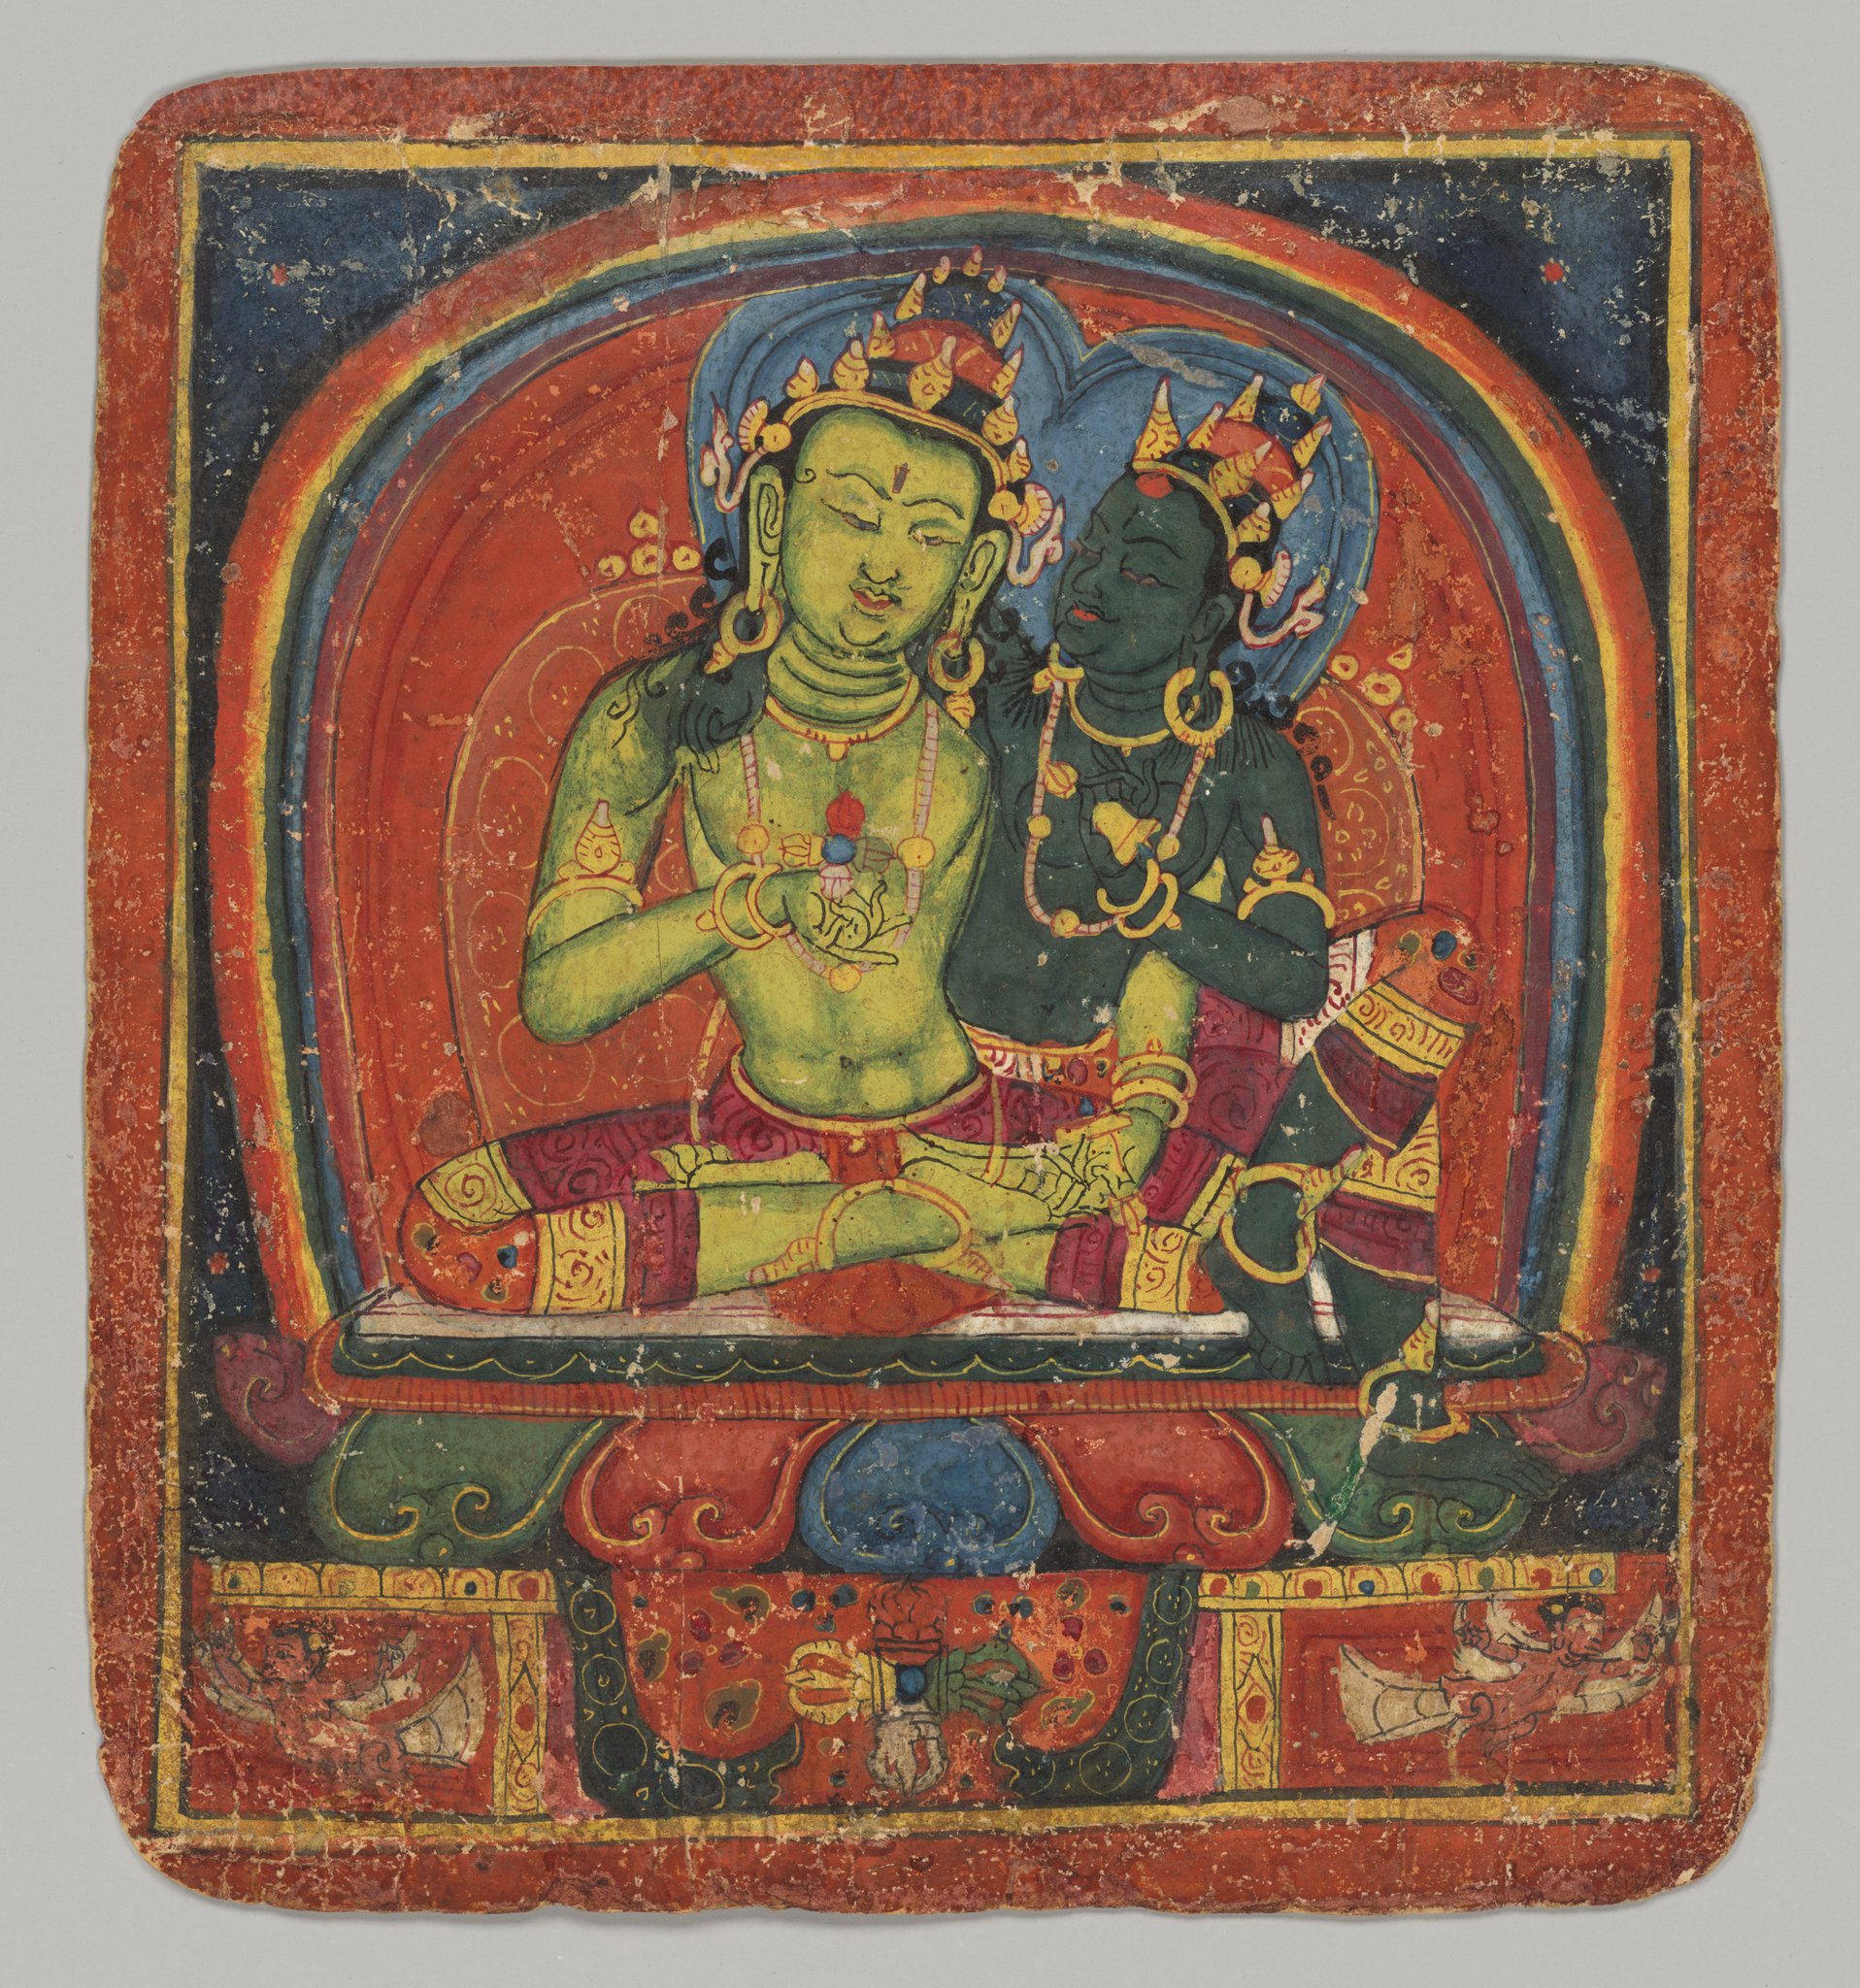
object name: initiation card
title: Initiation Card (Tsakalis): Amoghasiddhi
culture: tibetan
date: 1401-1433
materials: paper, watercolor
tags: amoghasiddhi,deities